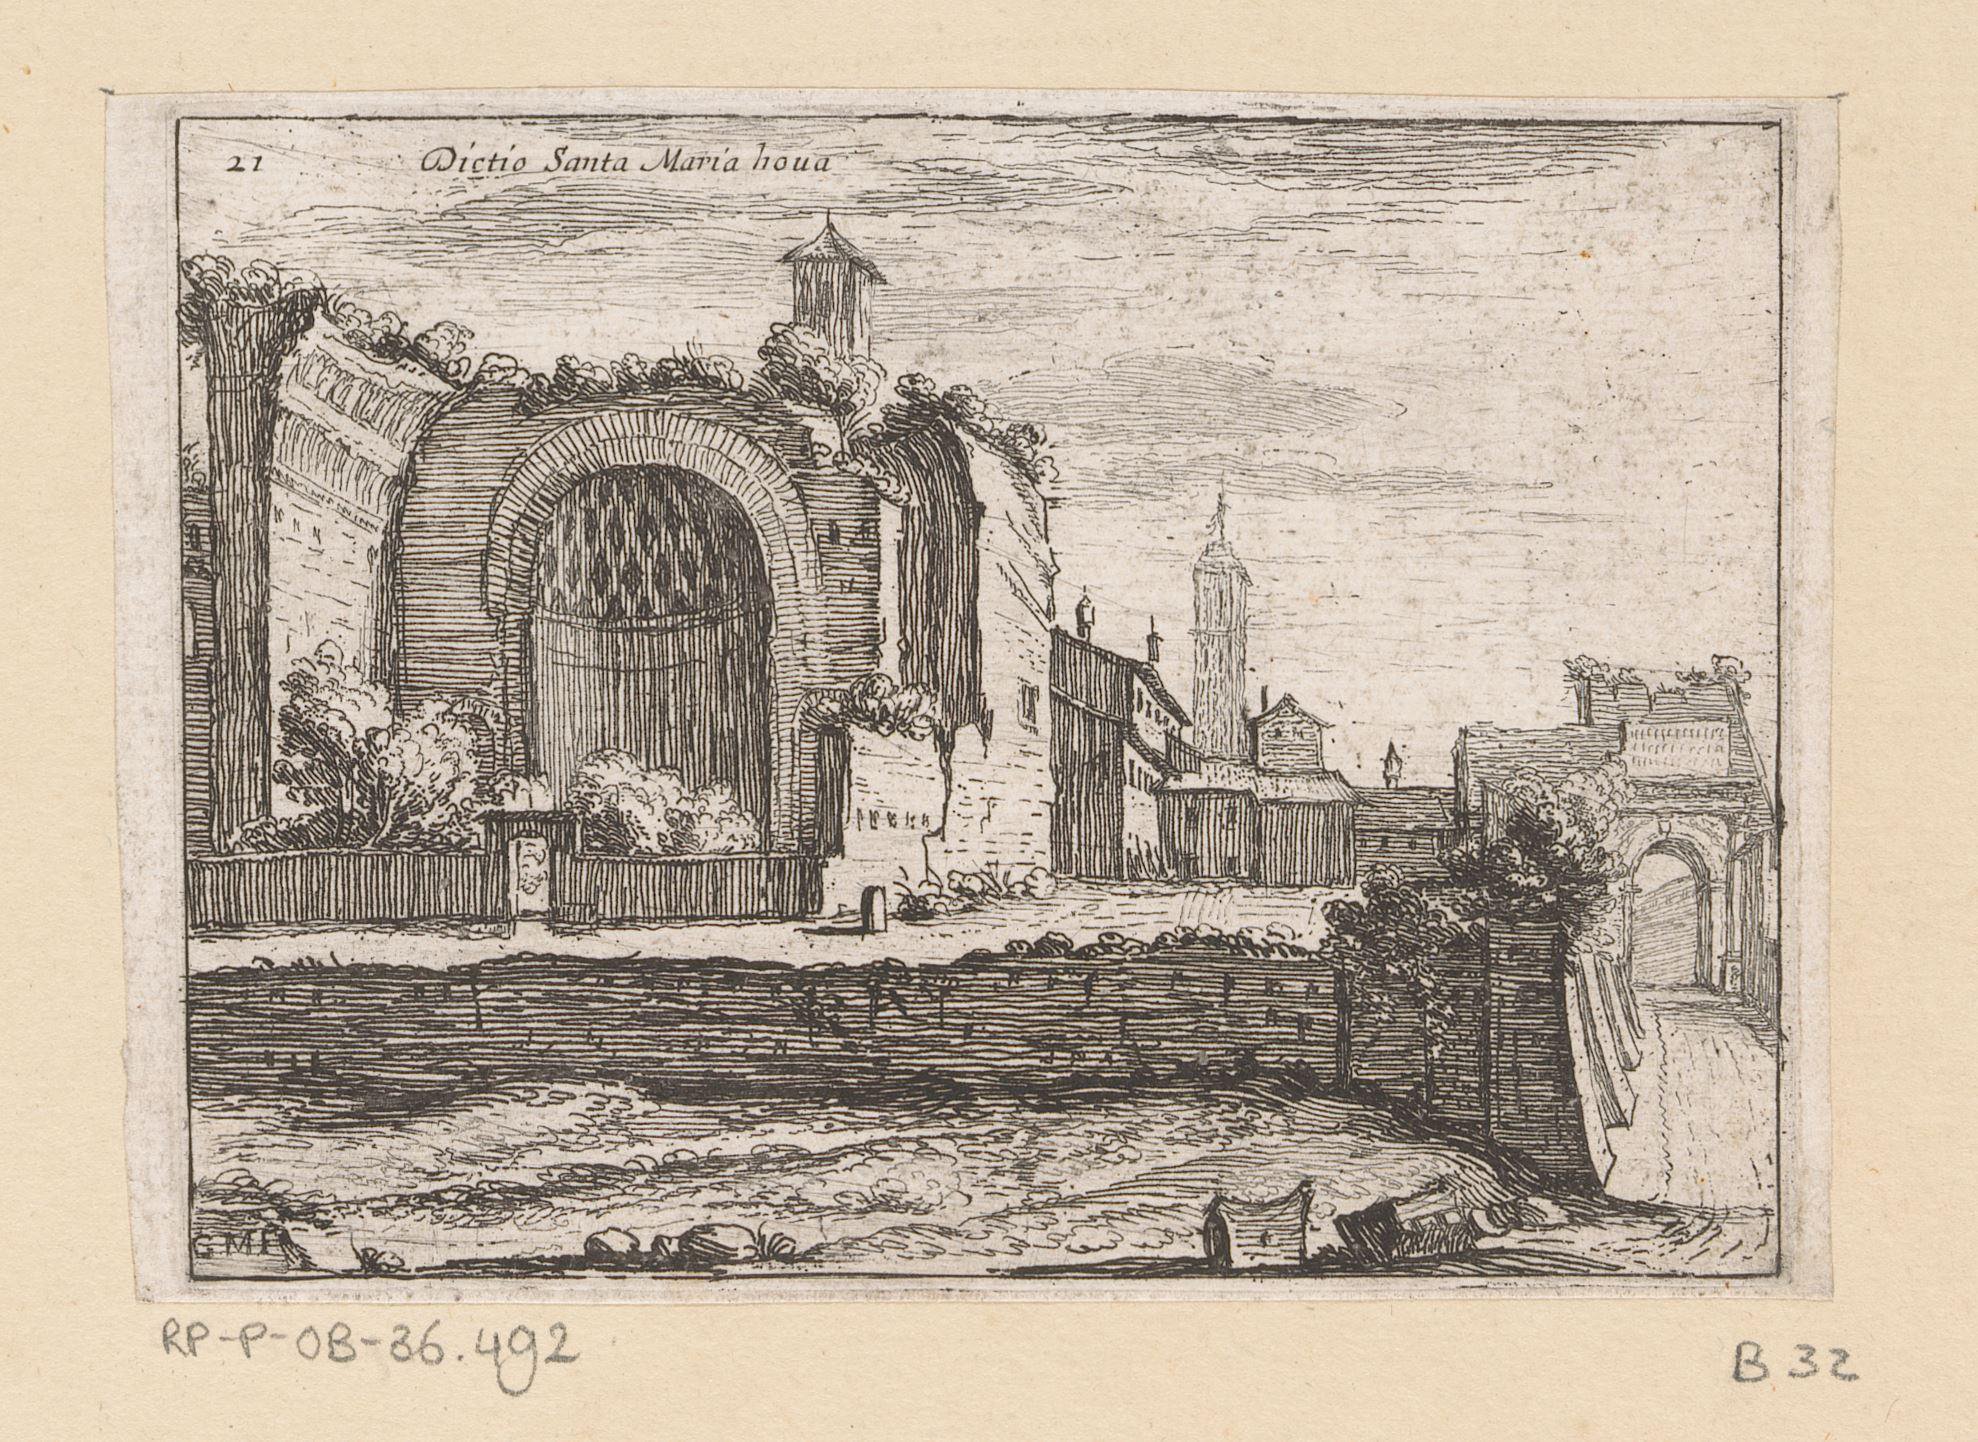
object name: print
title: Alcune vedute et prospettive di luoghi dishabitati di Roma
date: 1629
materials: paper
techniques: etching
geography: italy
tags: landscape with ruins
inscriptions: collector's mark: Lugt 2228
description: Gezicht op de resten van de Tempel van Venus en Roma te Rome. Op de achtergrond is de toren van de Santa Francesca Romana (voorheen de Santa Maria Nuova genoemd) zichtbaar.